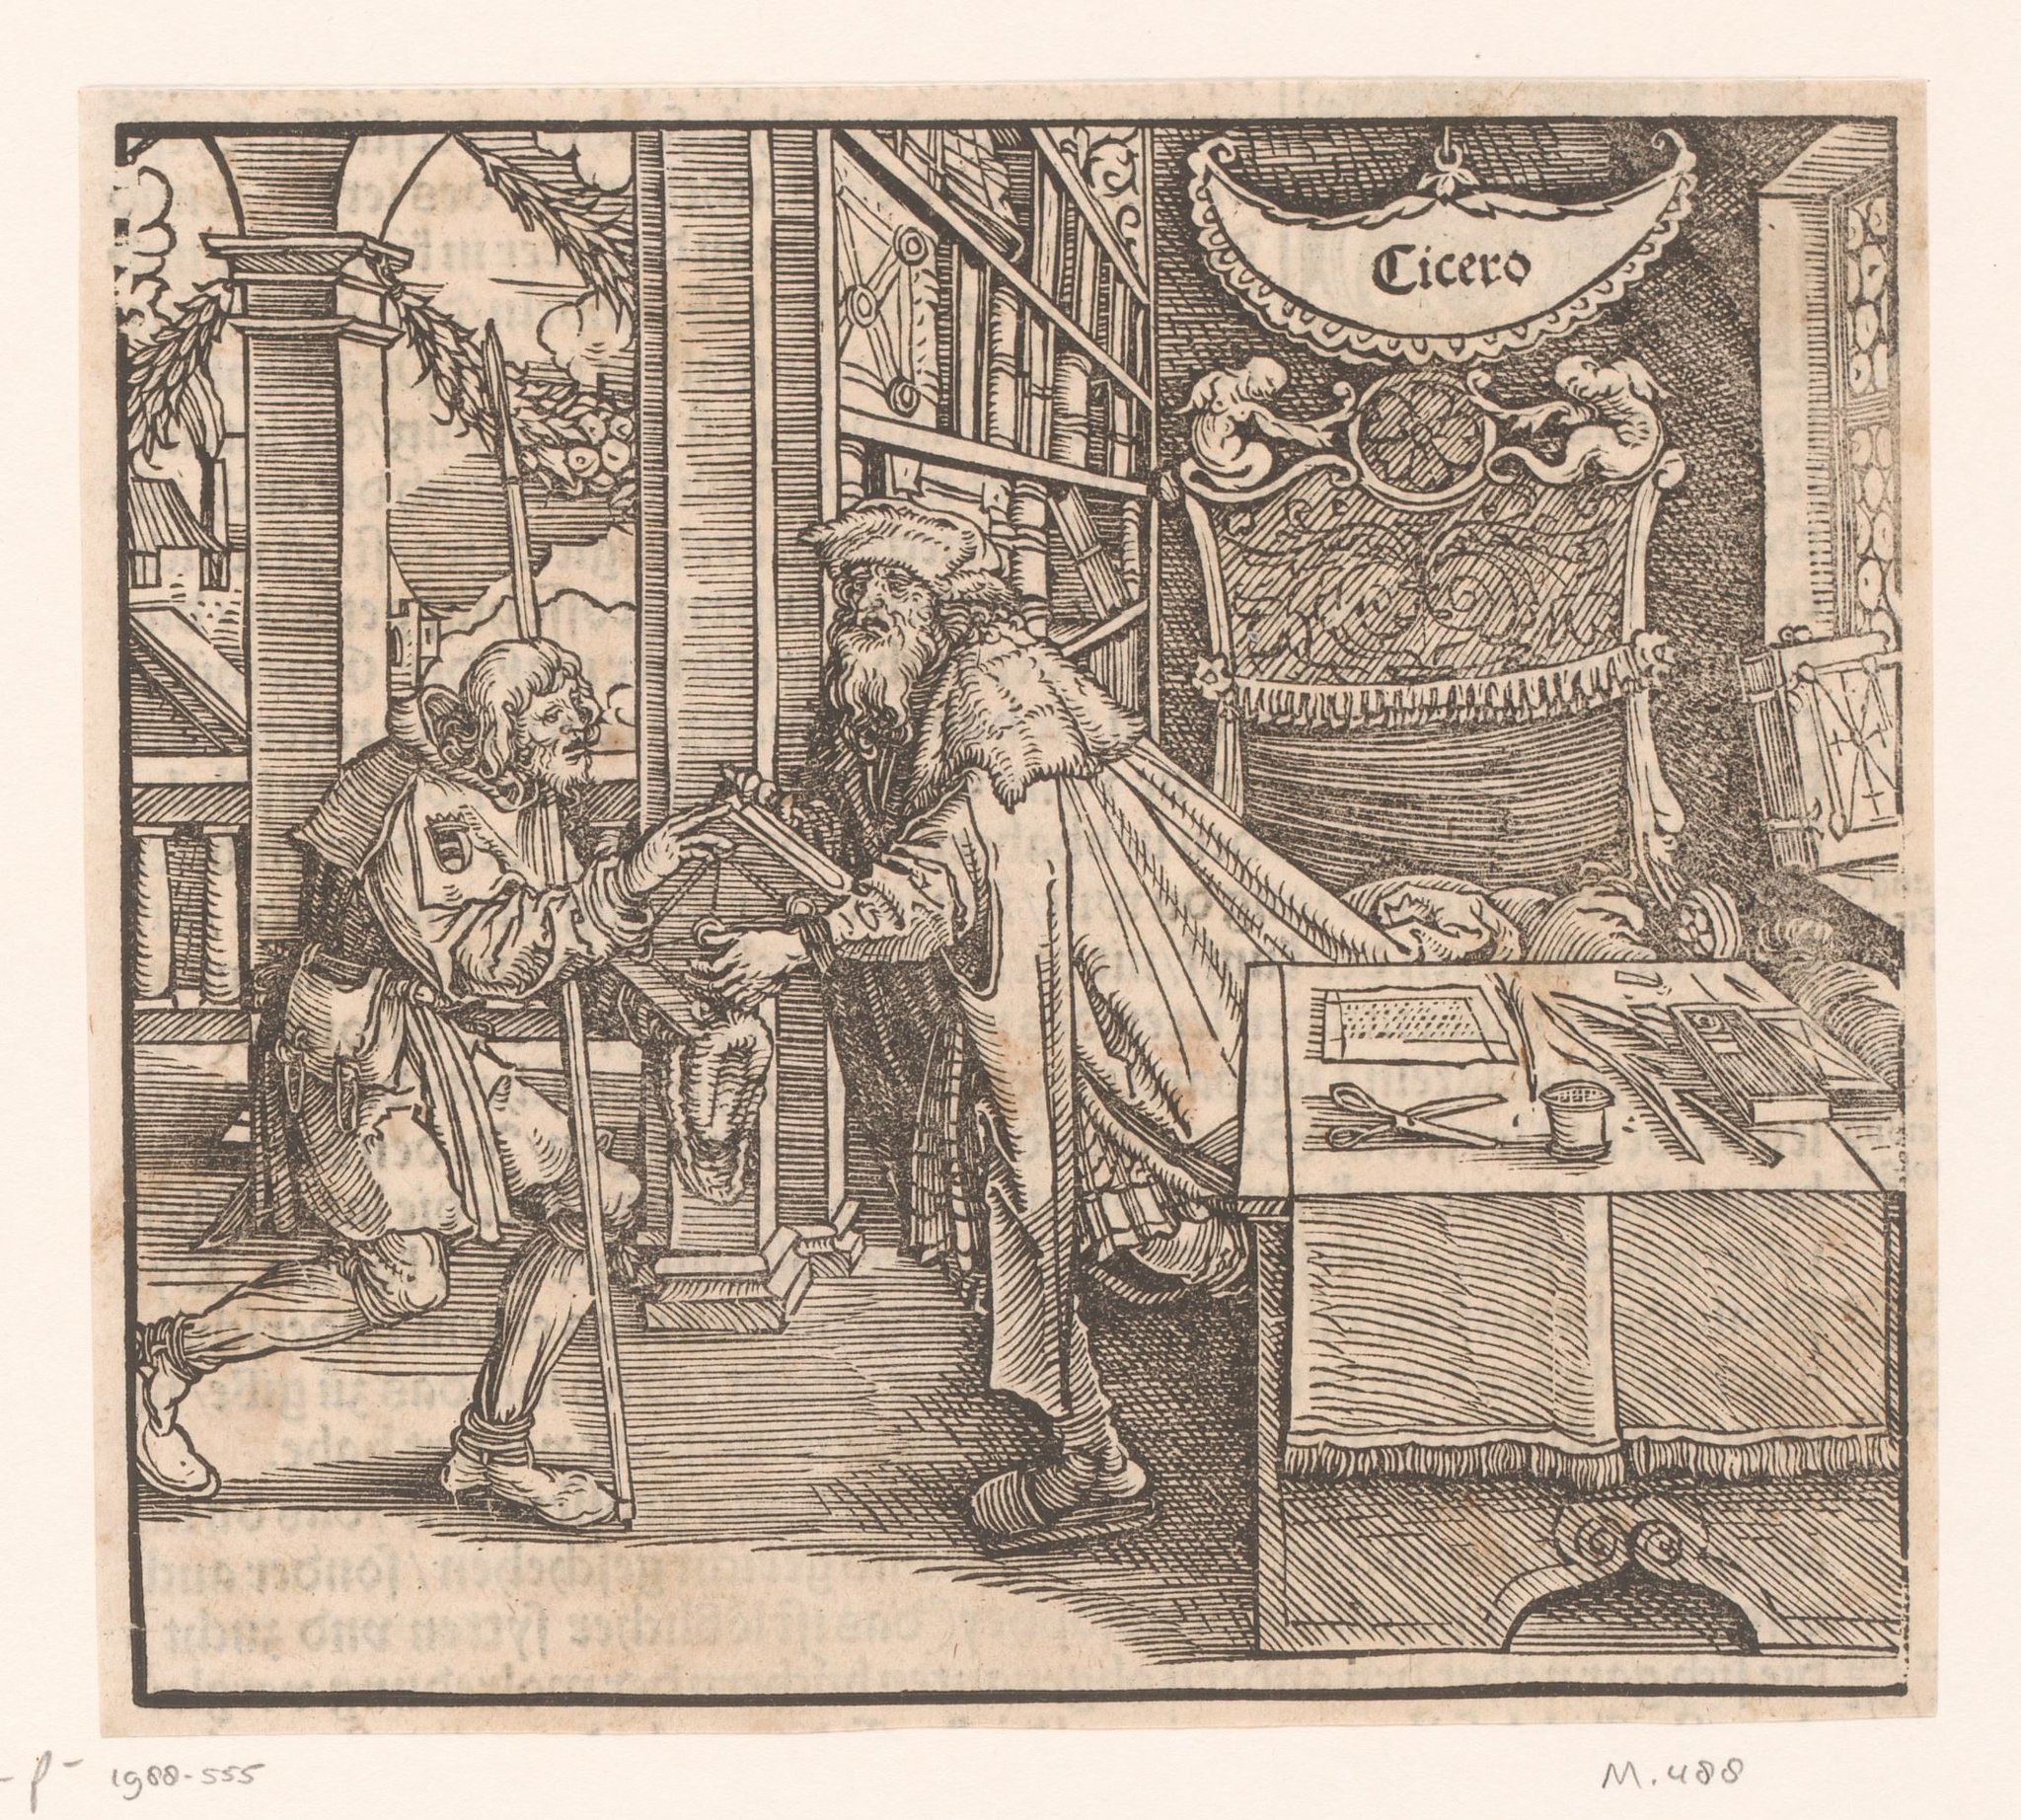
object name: book illustration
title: Cicero overhandigt zijn boek aan een bode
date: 1531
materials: paper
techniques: woodcut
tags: marcus tullius cicero, portrait of a writer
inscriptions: collector's mark: Lugt 2228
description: Prent voor het eerst gebruikt in: Cicero, Marcus Tullius. Officia M.T.C. Ein Buch So Marcus Tullius Cicero (...). Augsburg: Heinrich Steiner, 1531.